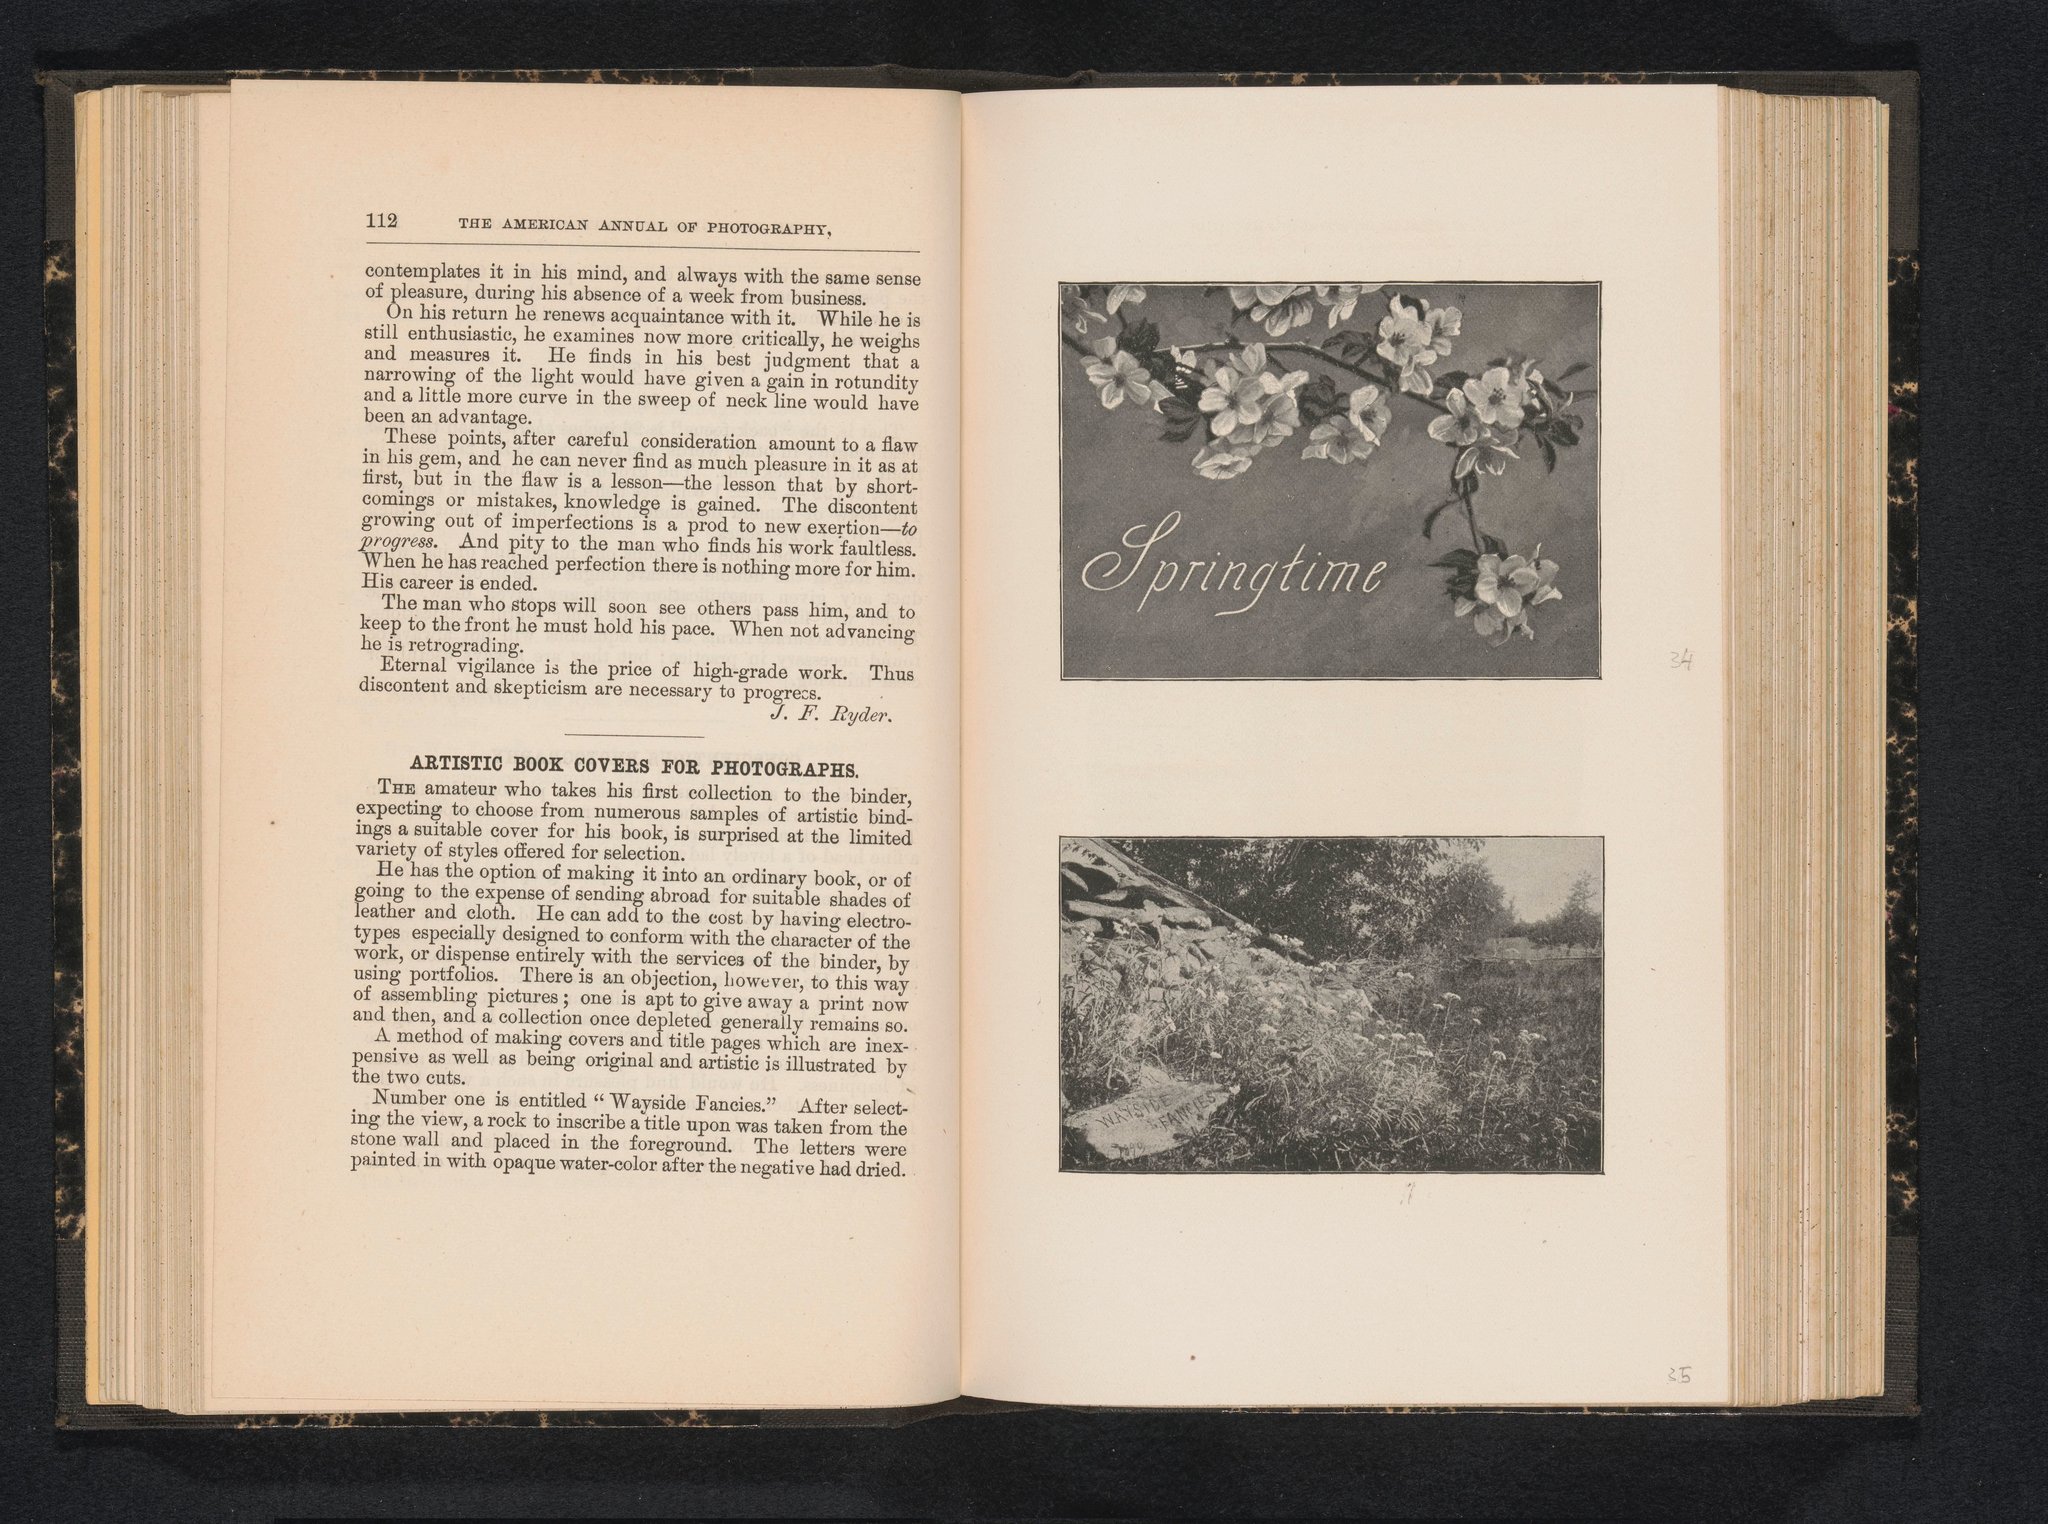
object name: photomechanical print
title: Gezicht op een weide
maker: Anonymous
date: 1887-1907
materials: paper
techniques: autotype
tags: meadow, pasture